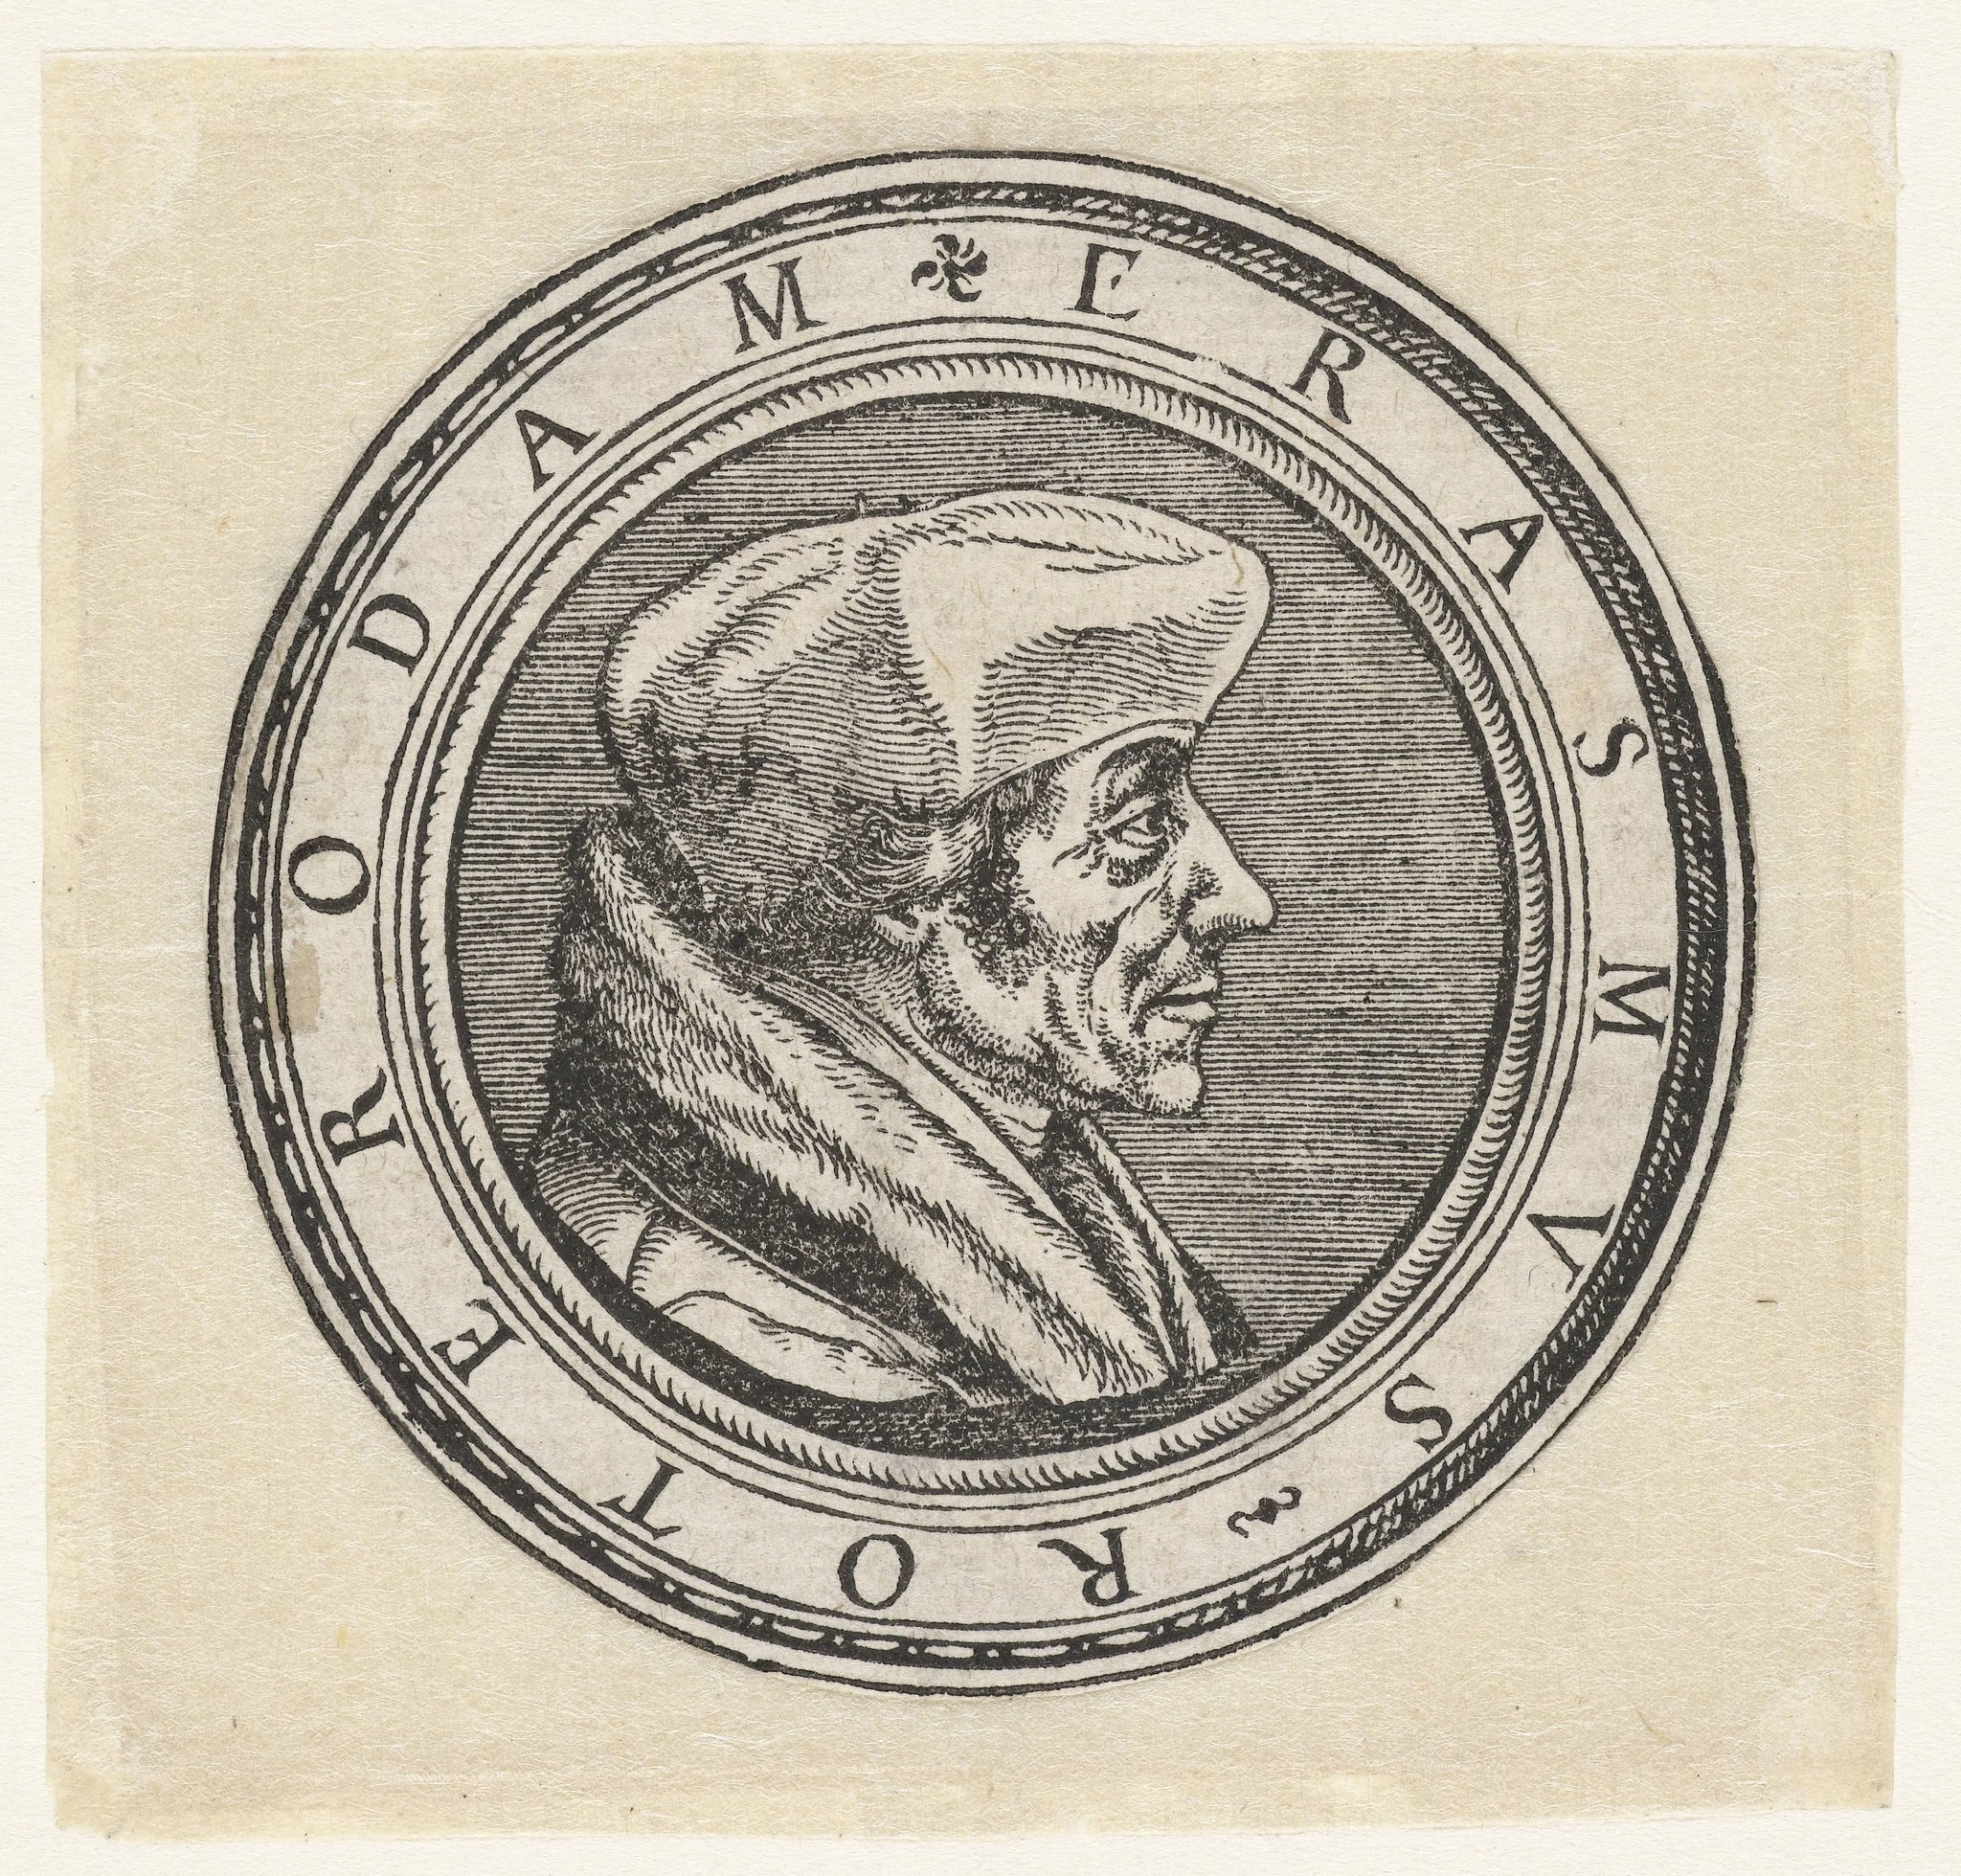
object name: print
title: Portret van Erasmus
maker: hans holbein (der jüngere)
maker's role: draughtsman, painter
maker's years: 1497-1543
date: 1533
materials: paper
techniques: woodcut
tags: desiderius erasmus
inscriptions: collector's mark: Lugt 654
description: Houtblok gebruikt voor: Desiderus Erasmus, Adagiorum opus ... exquisitiore quam antehac unquam cura recognitum..., Basel, Froben Heirs, March 1533 (eerste druk). Deze druk is waarschijnlijk afkomstig uit een andere edititie, zie Hollstein German 91. Prent aanwezig op veiling P. Davidsohn, Leipzig, datum onbekend, nr. 303.